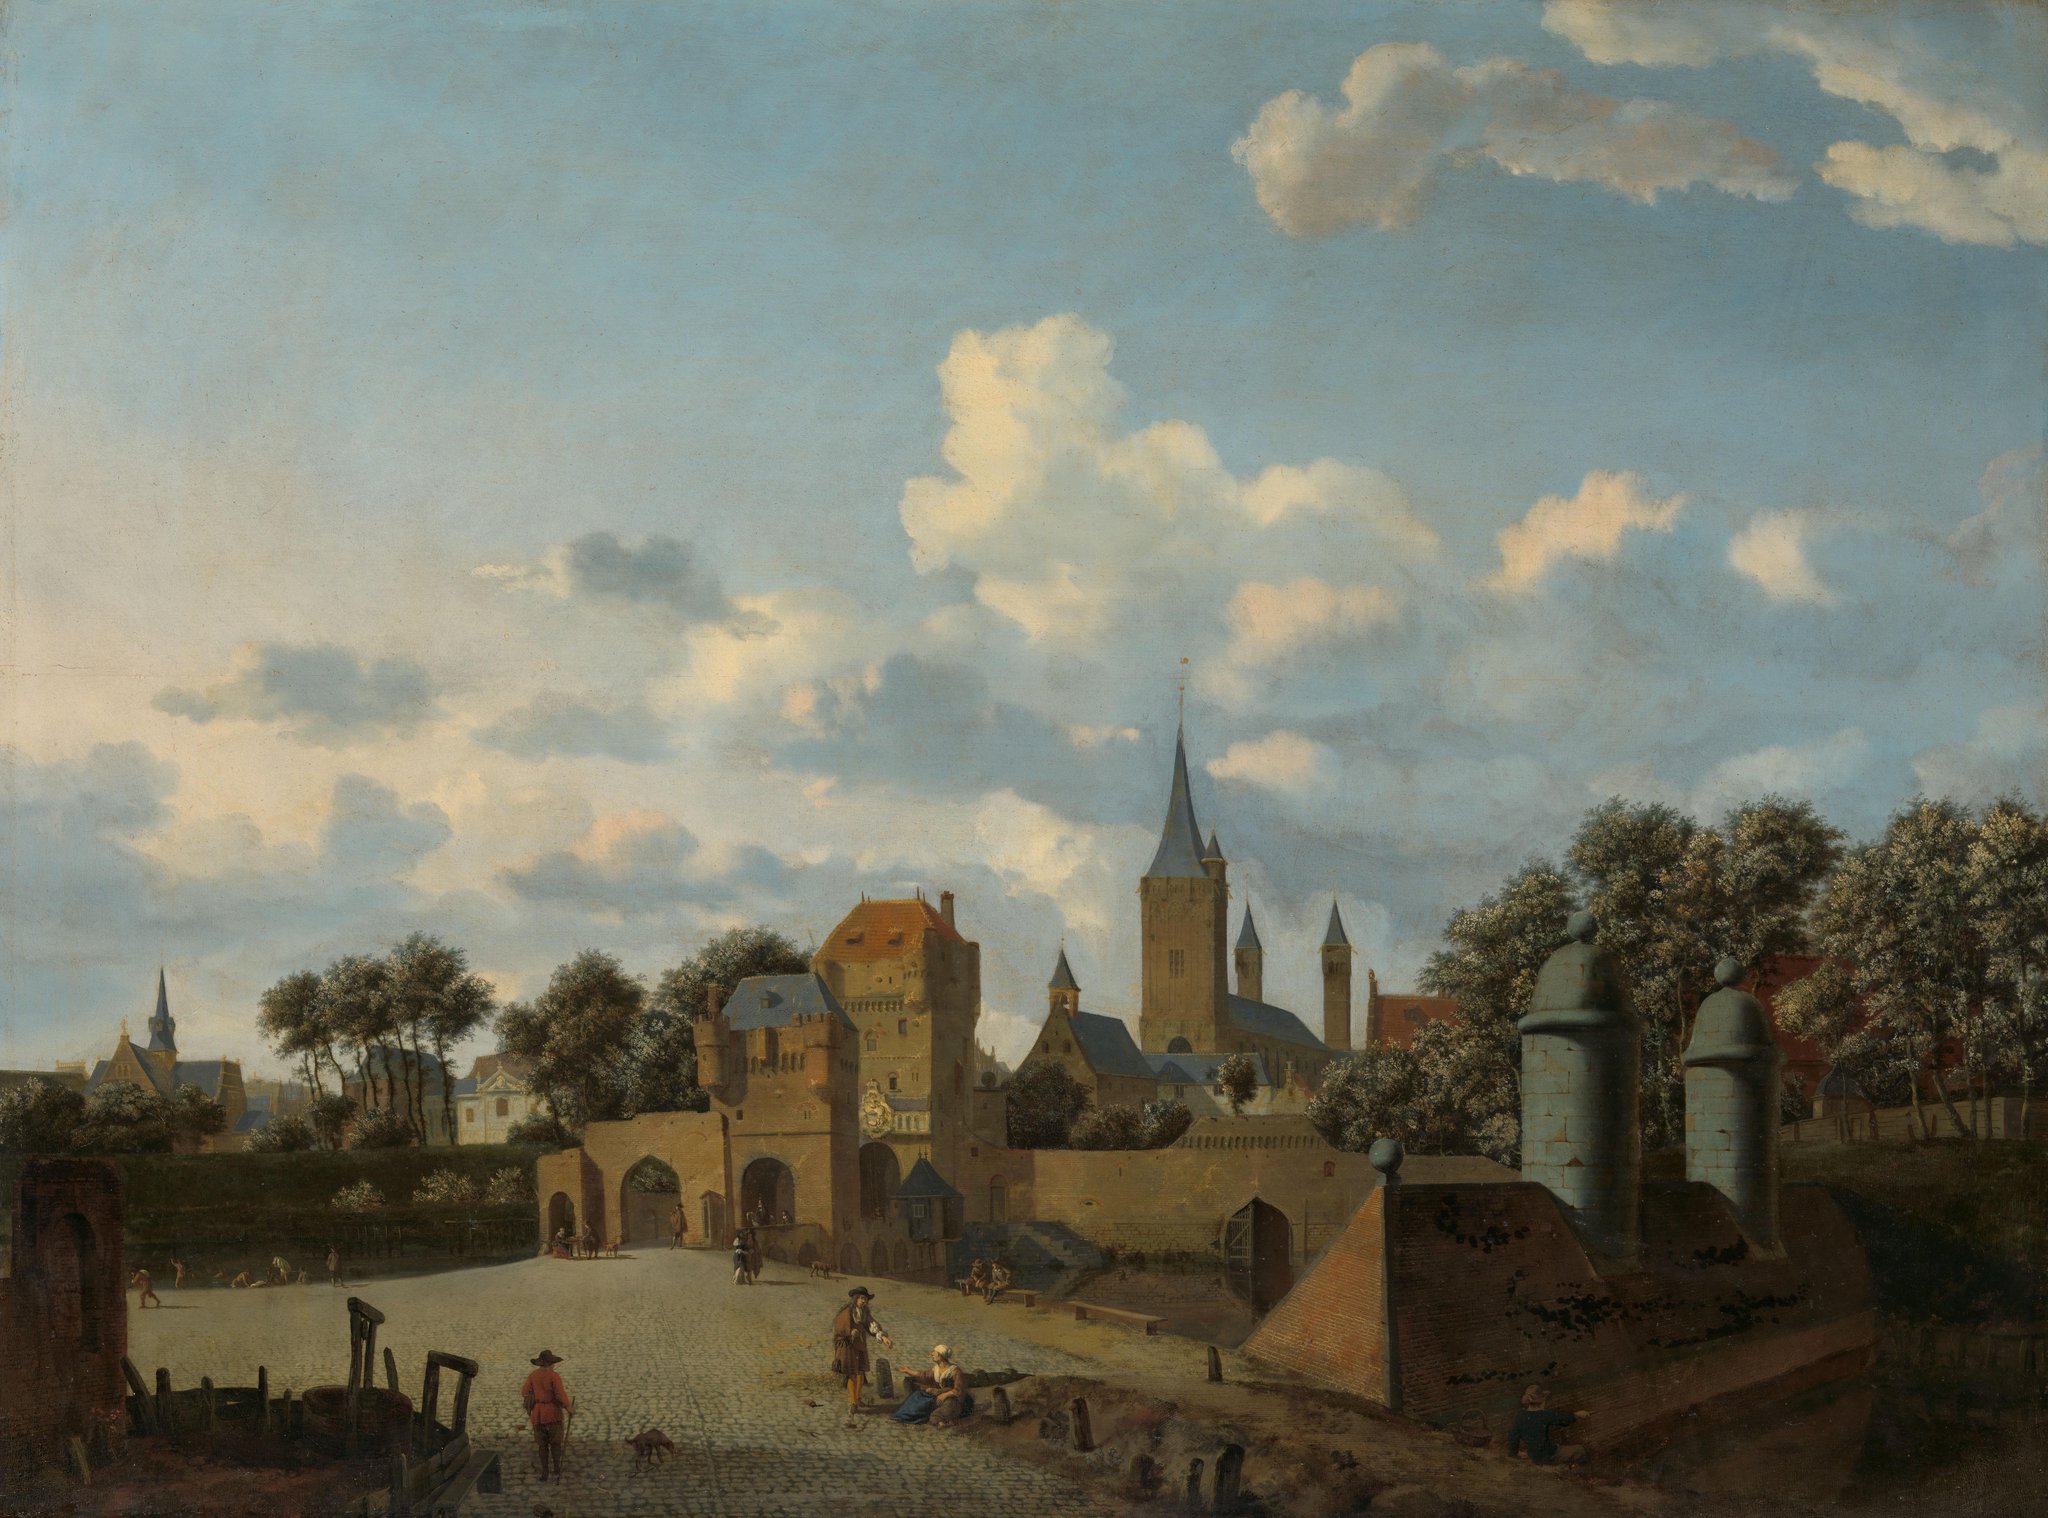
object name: painting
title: The Church of St Severin in Cologne in an Imaginary Setting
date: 1660-1672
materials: oil, panel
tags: church (exterior), prospect of city, town panorama, silhouette of city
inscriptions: signature: ‘I. v.d. Heyde’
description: De stadsgezichten van Jan van der Heyden waren niet altijd helemaal natuurgetrouw. Op dit schilderij lijkt hij gebouwen uit verschillende steden te hebben gecombineerd. Zo is de kerk vermoedelijk de Sankt Severin in Keulen en lijkt de dubbele poort op de Waterpoort van Emmerich. De driehoekige dam met de twee torentjes (rechts) bevond zich in werkelijkheid in de verdedigingsgracht rond Amsterdam.